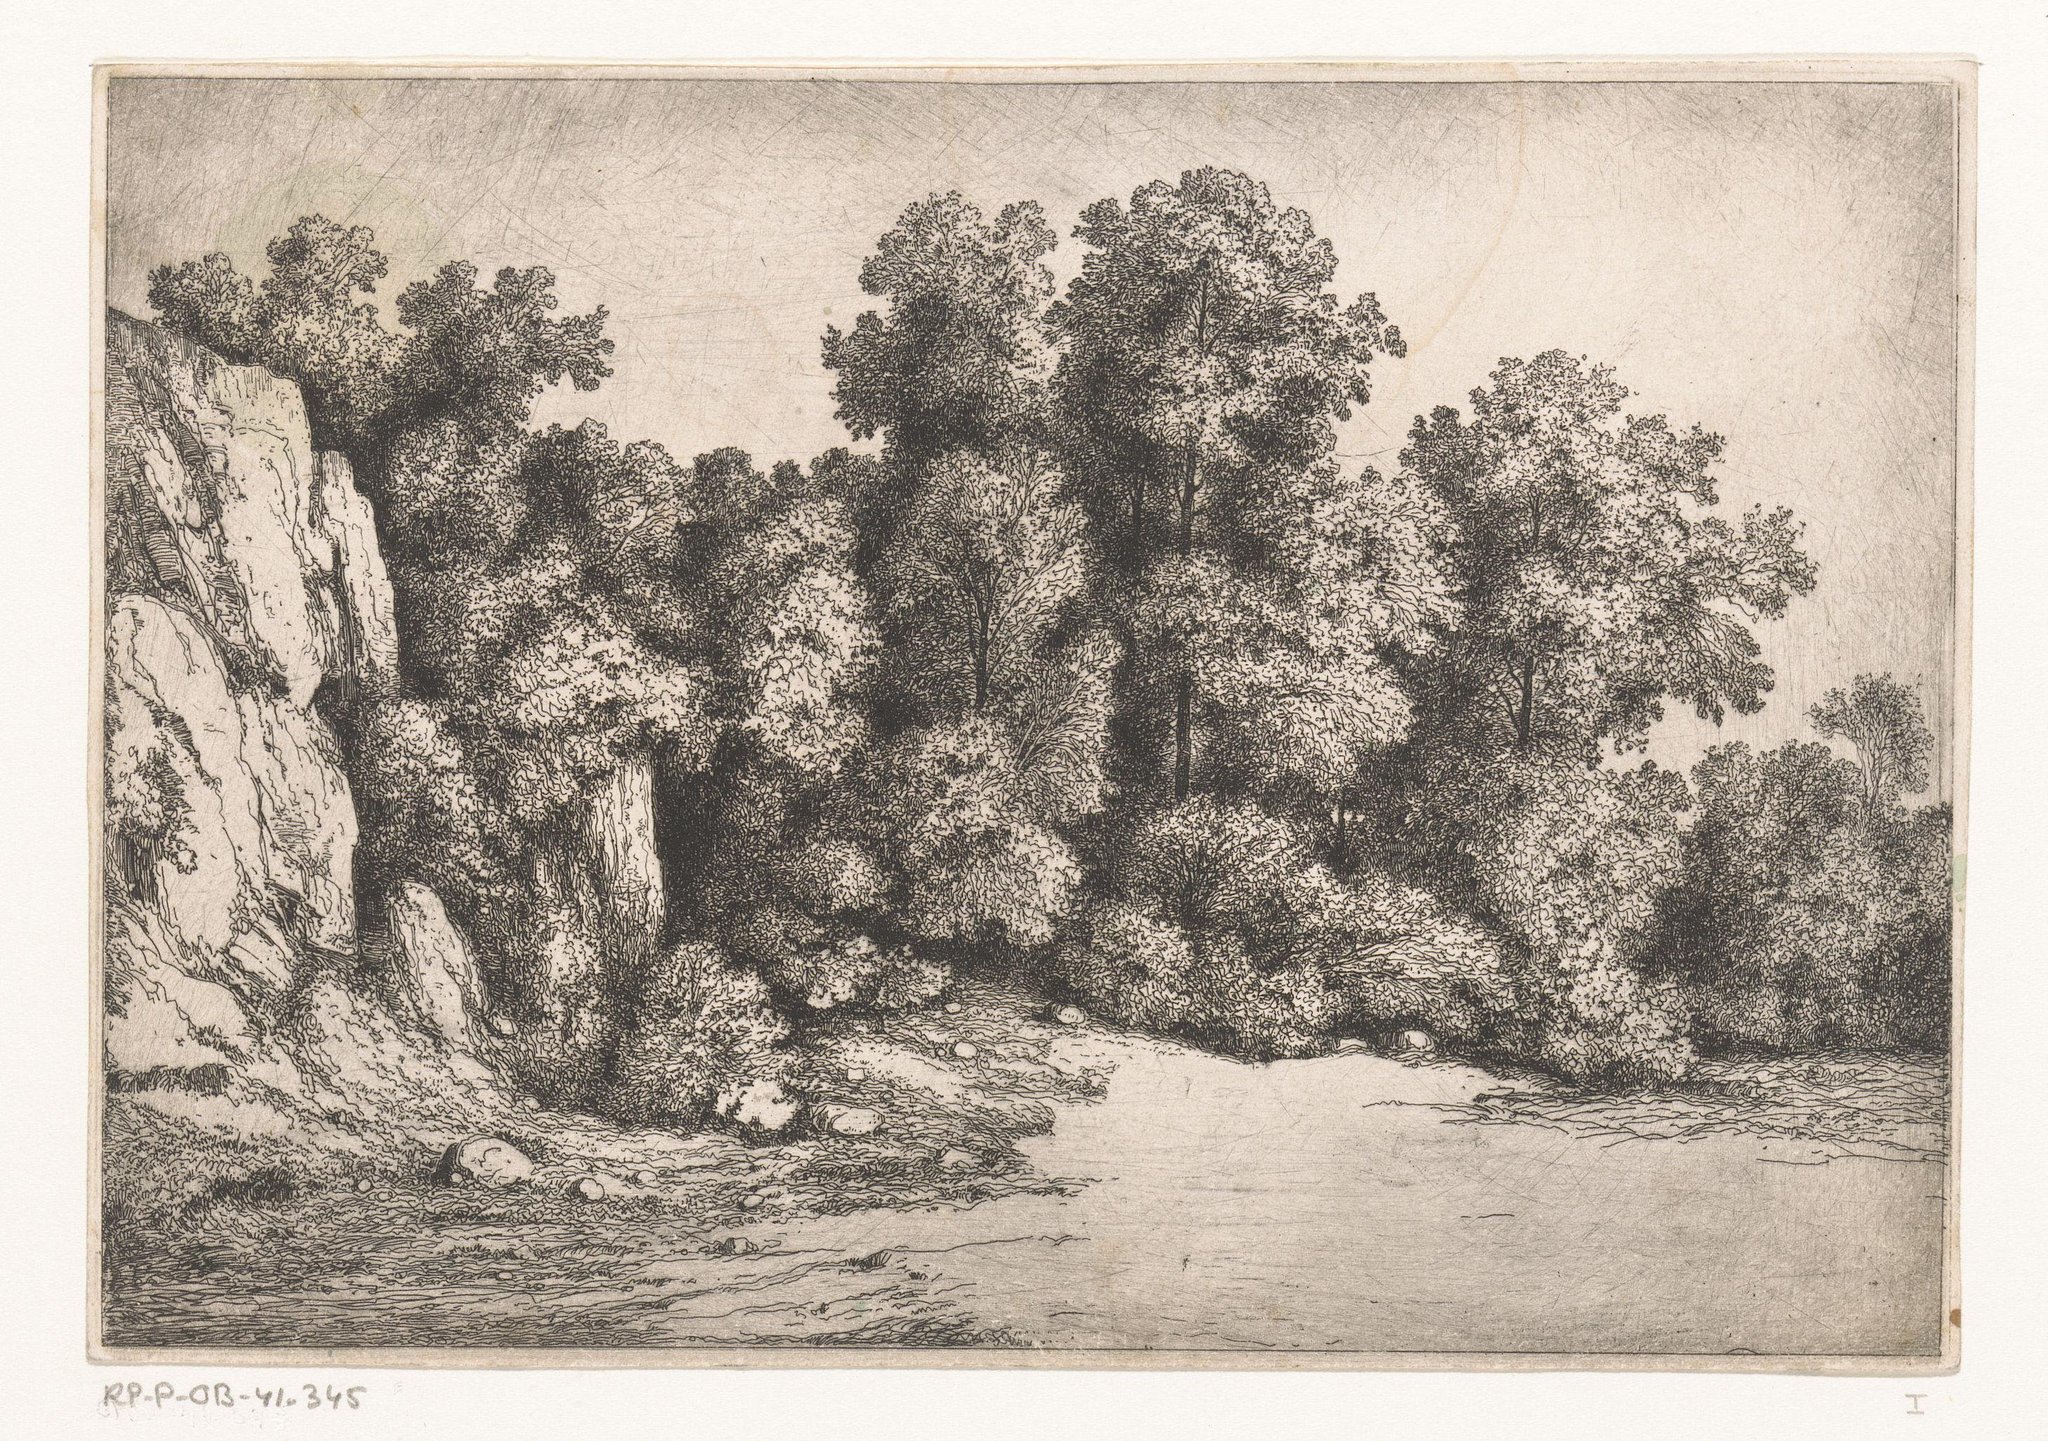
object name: print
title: Bomen bij een rotswand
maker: jean alexis achard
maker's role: print maker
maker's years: 1807-1884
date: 1817-1884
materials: paper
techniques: etching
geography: france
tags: trees, rocks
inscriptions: collector's mark: Lugt 2228, inscription: ‘1er état / Premier epr. d'essai unique [?]’